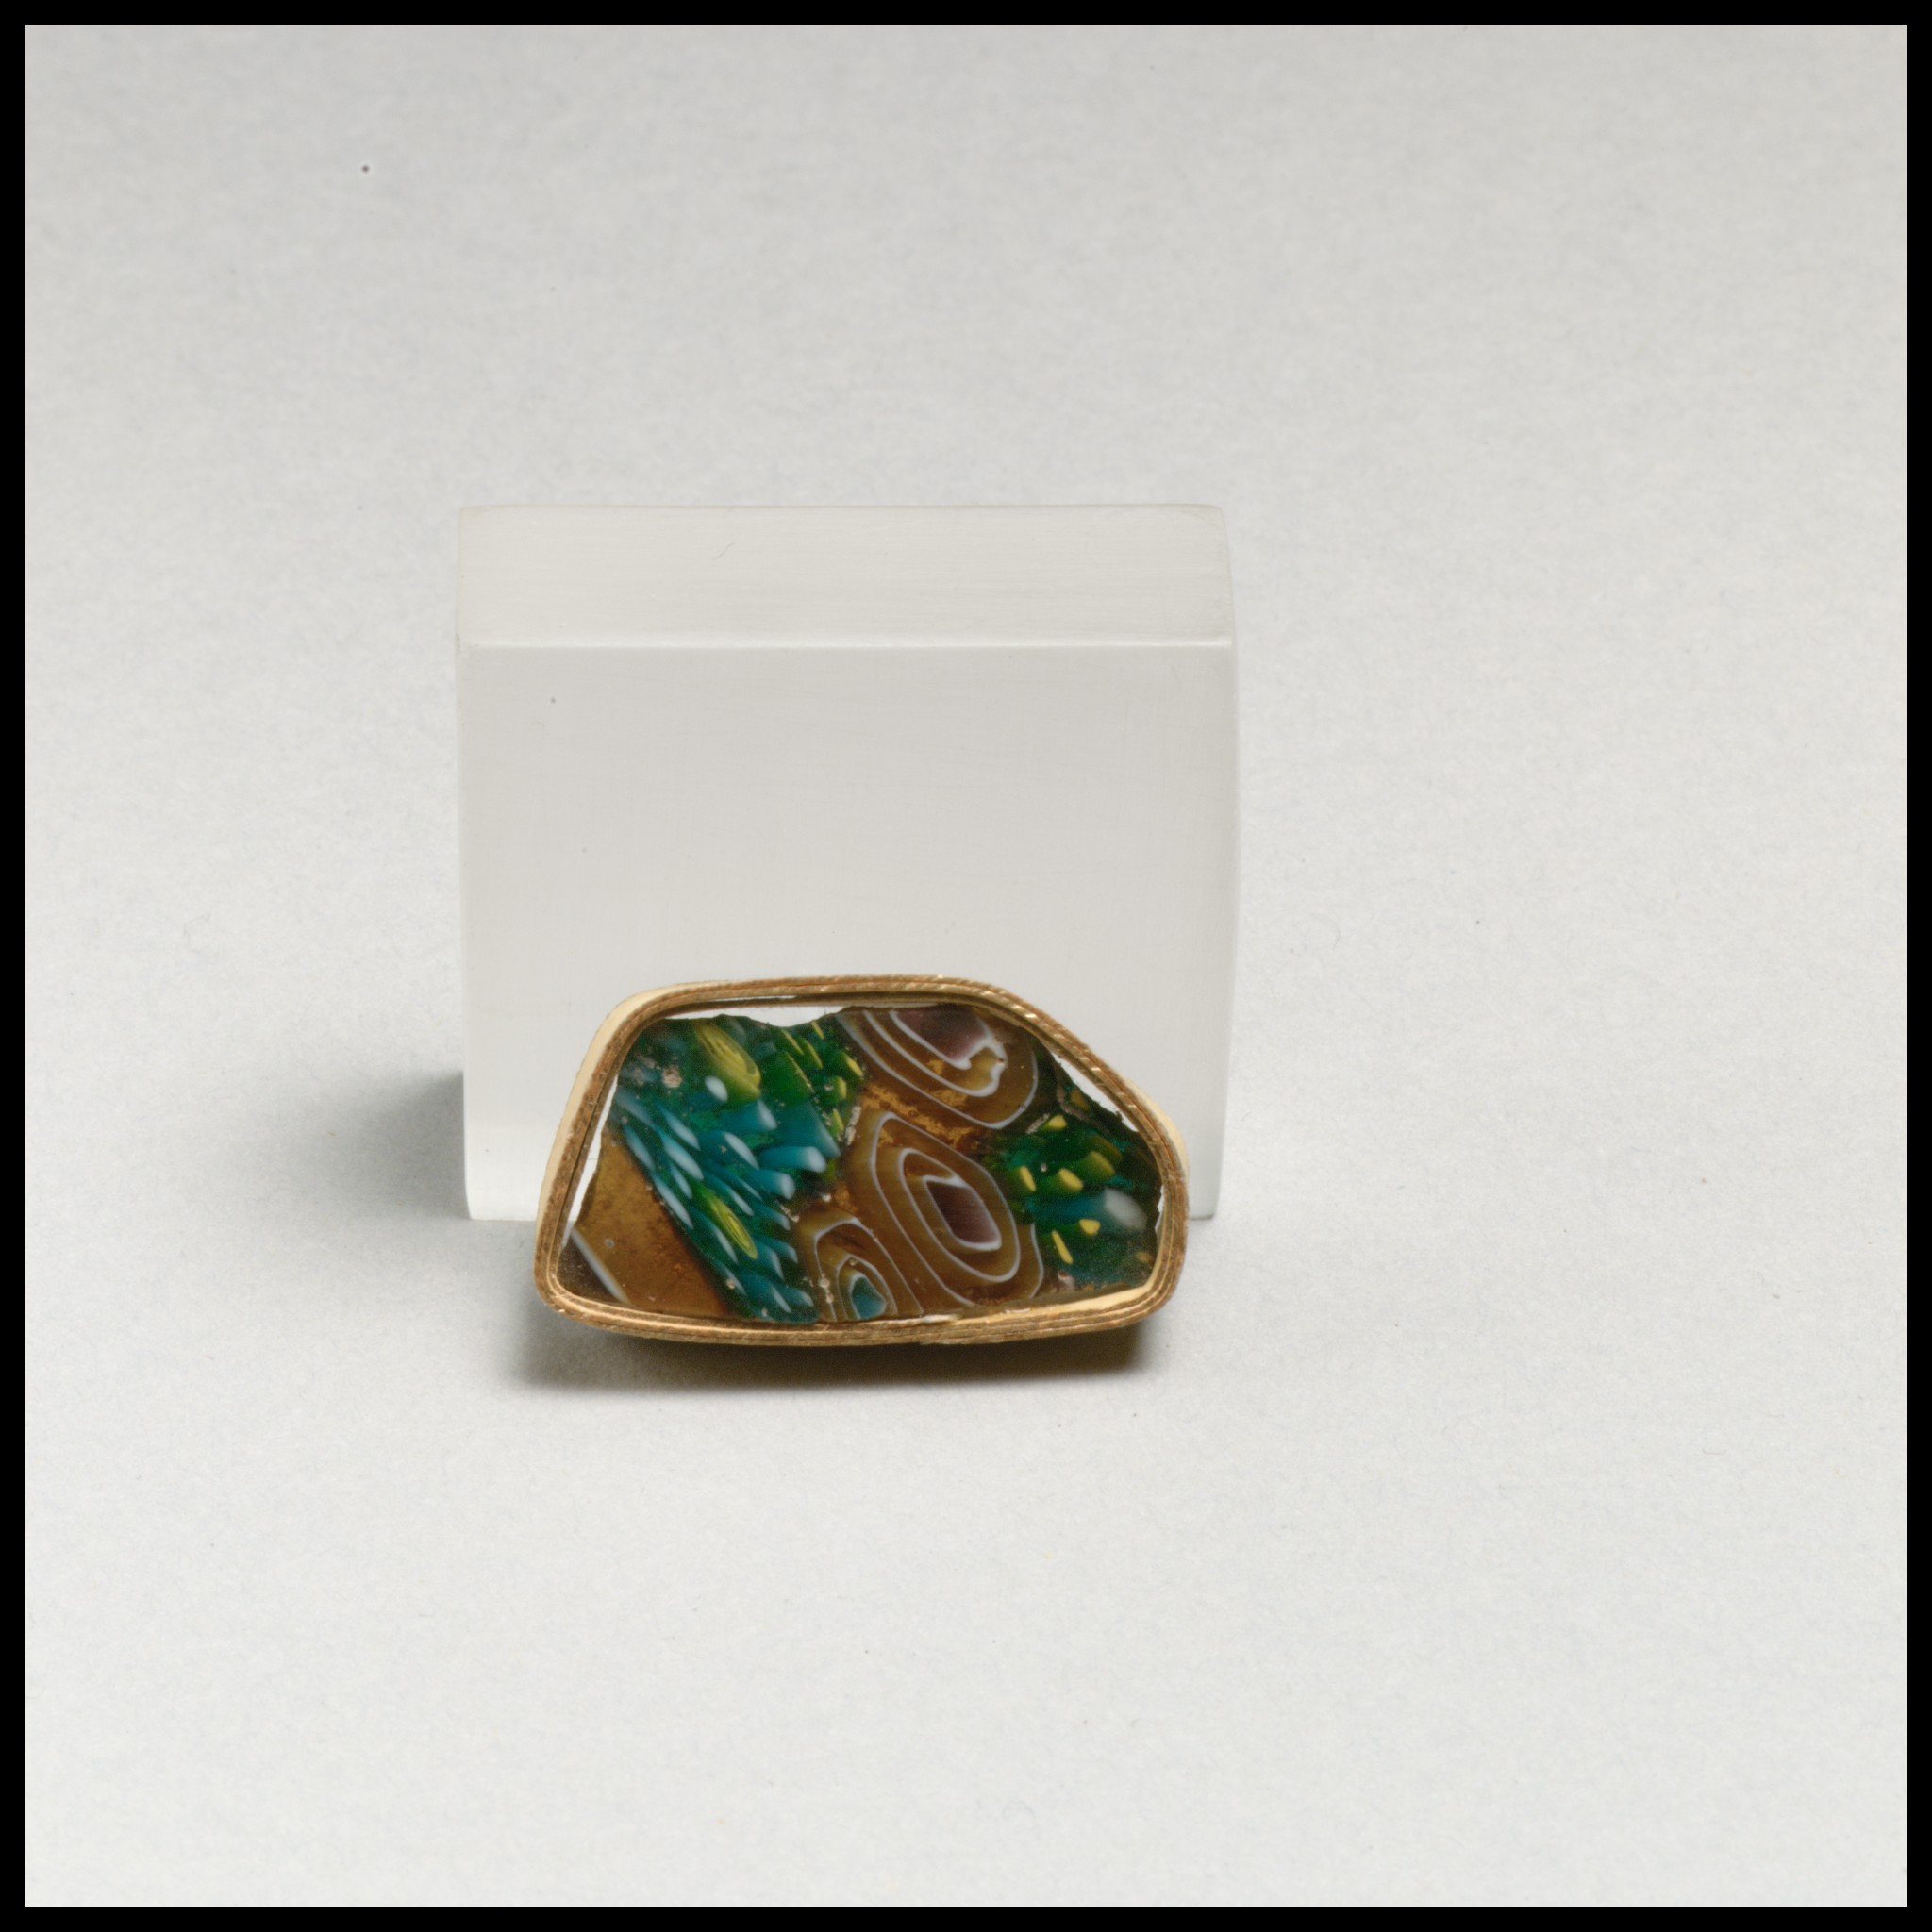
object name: fragment, mosaic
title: Glass mosaic fragment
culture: roman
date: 34 BCE-33 CE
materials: glass